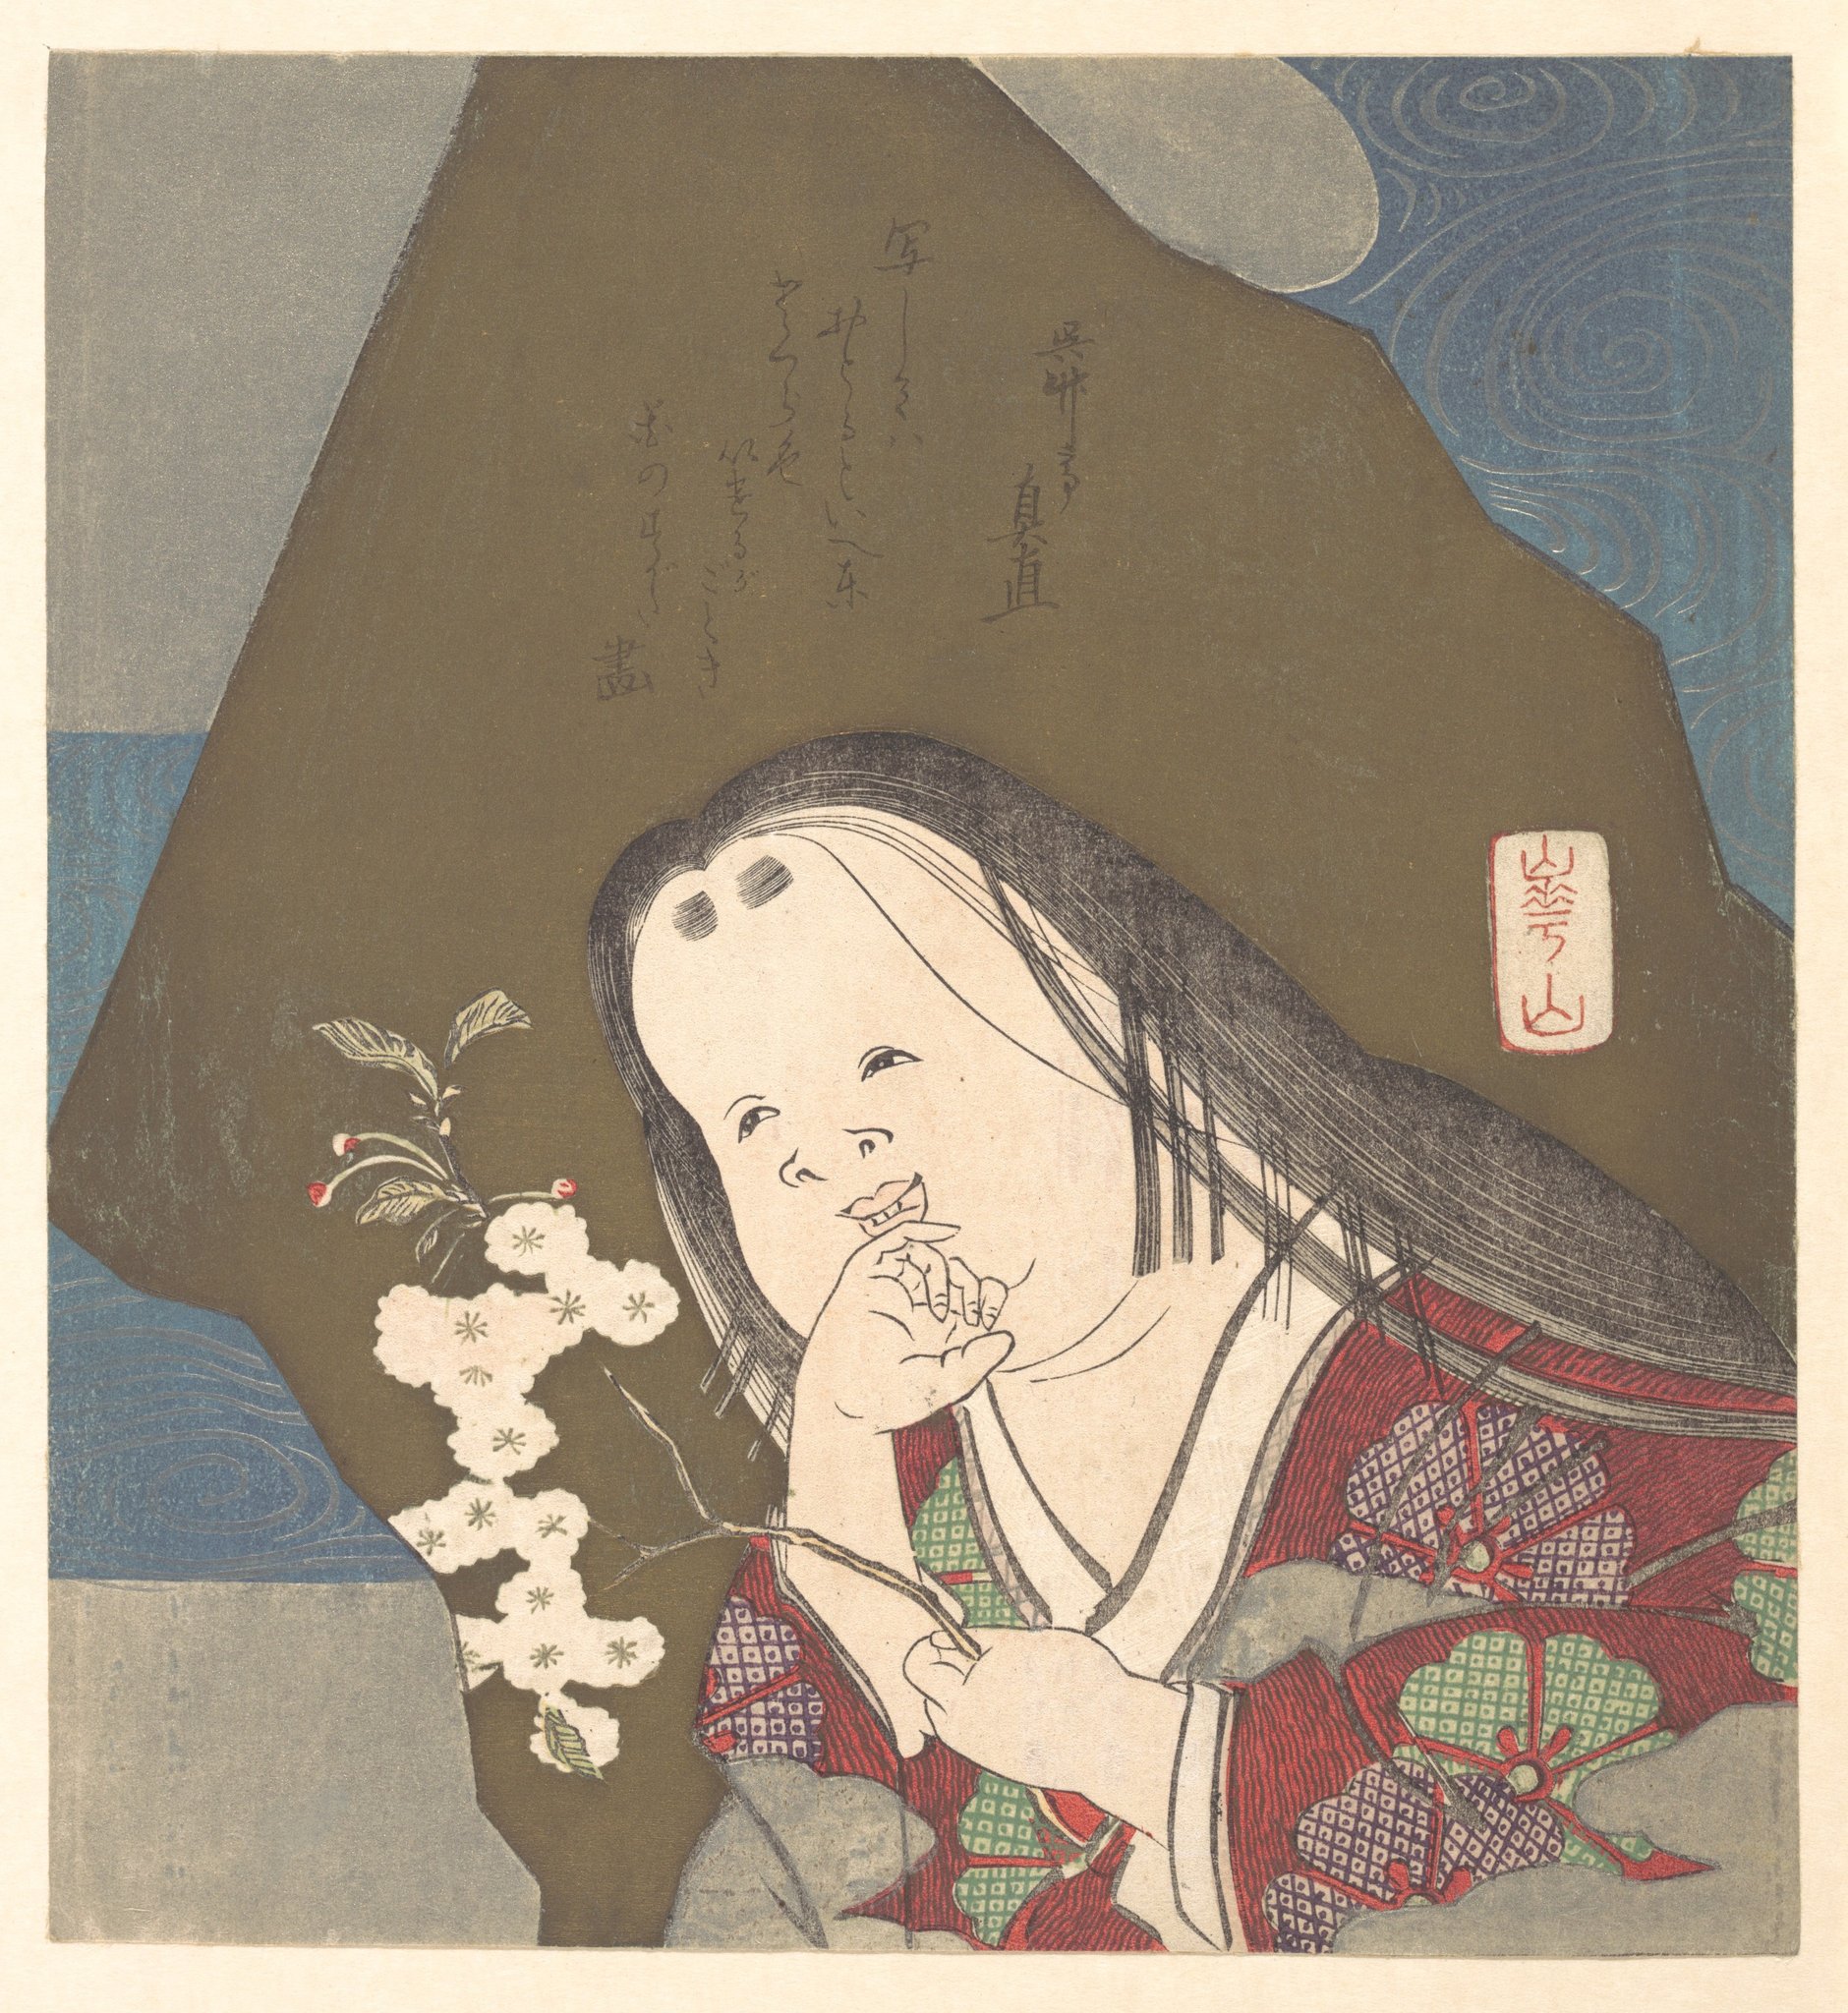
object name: woodblock print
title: Otafuku Holding a Branch of Double White Cherry Blossoms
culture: japanese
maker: watanabe kazan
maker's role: artist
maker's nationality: japanese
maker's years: -1841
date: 1840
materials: ink, paper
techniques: surimono, woodblock print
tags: women,flowers